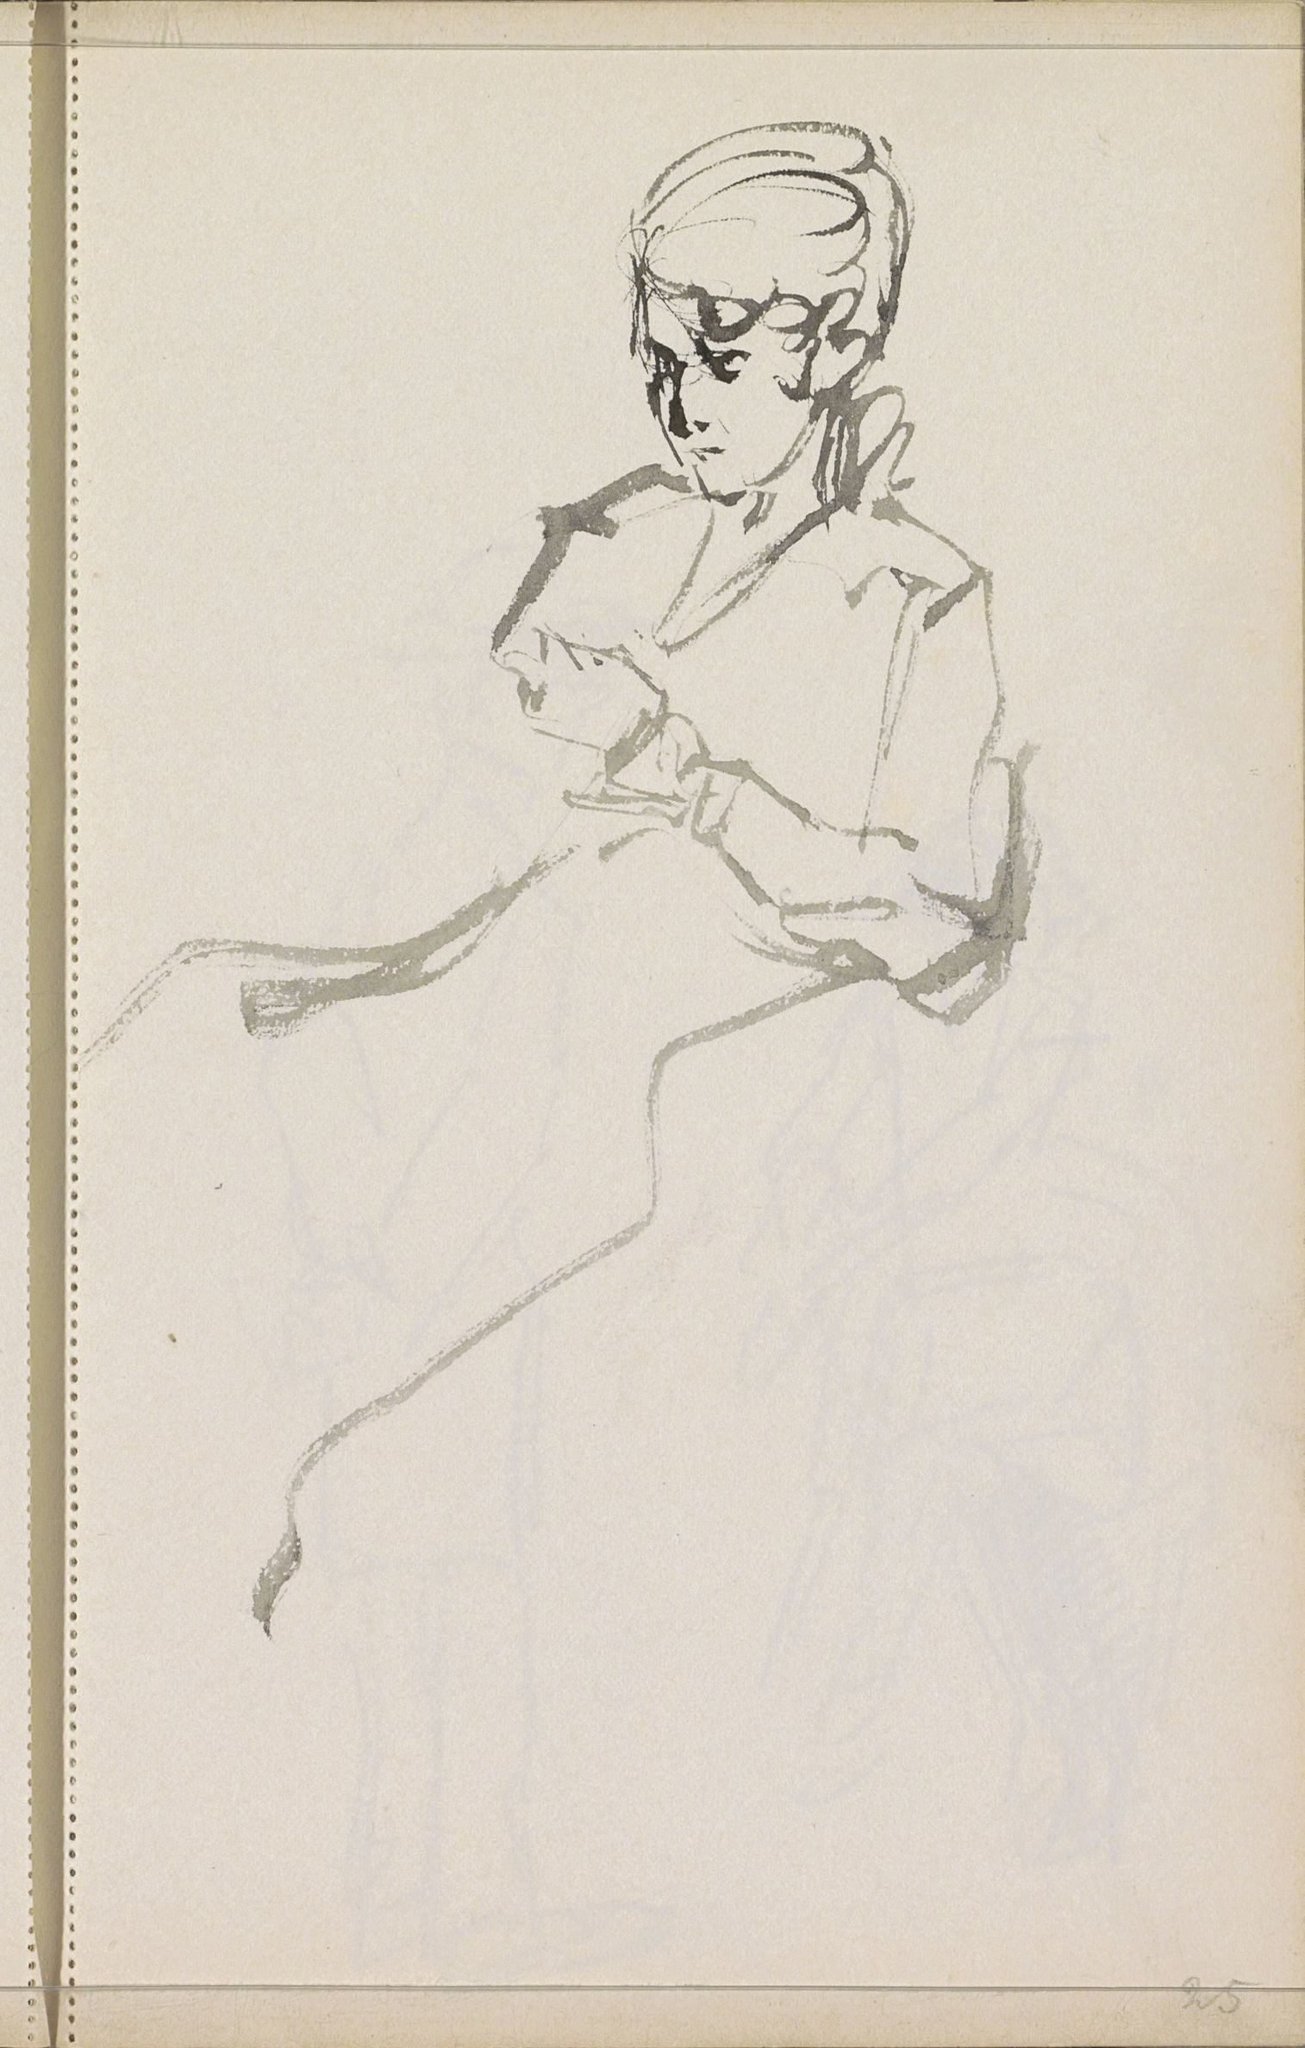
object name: sketchbook leaf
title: Zittende vrouw met haar handen voor haar borst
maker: isaac israels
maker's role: draughtsman, painter, print maker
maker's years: 1865-1934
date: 1875-1934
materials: paper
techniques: brush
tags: adult woman (+ sitting), (other forms of) needlework, e.g.: crocheting, knitting, embroidering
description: Mogelijk handwerkend. Blad 25 recto uit schetsboek LII met 43 bladen.